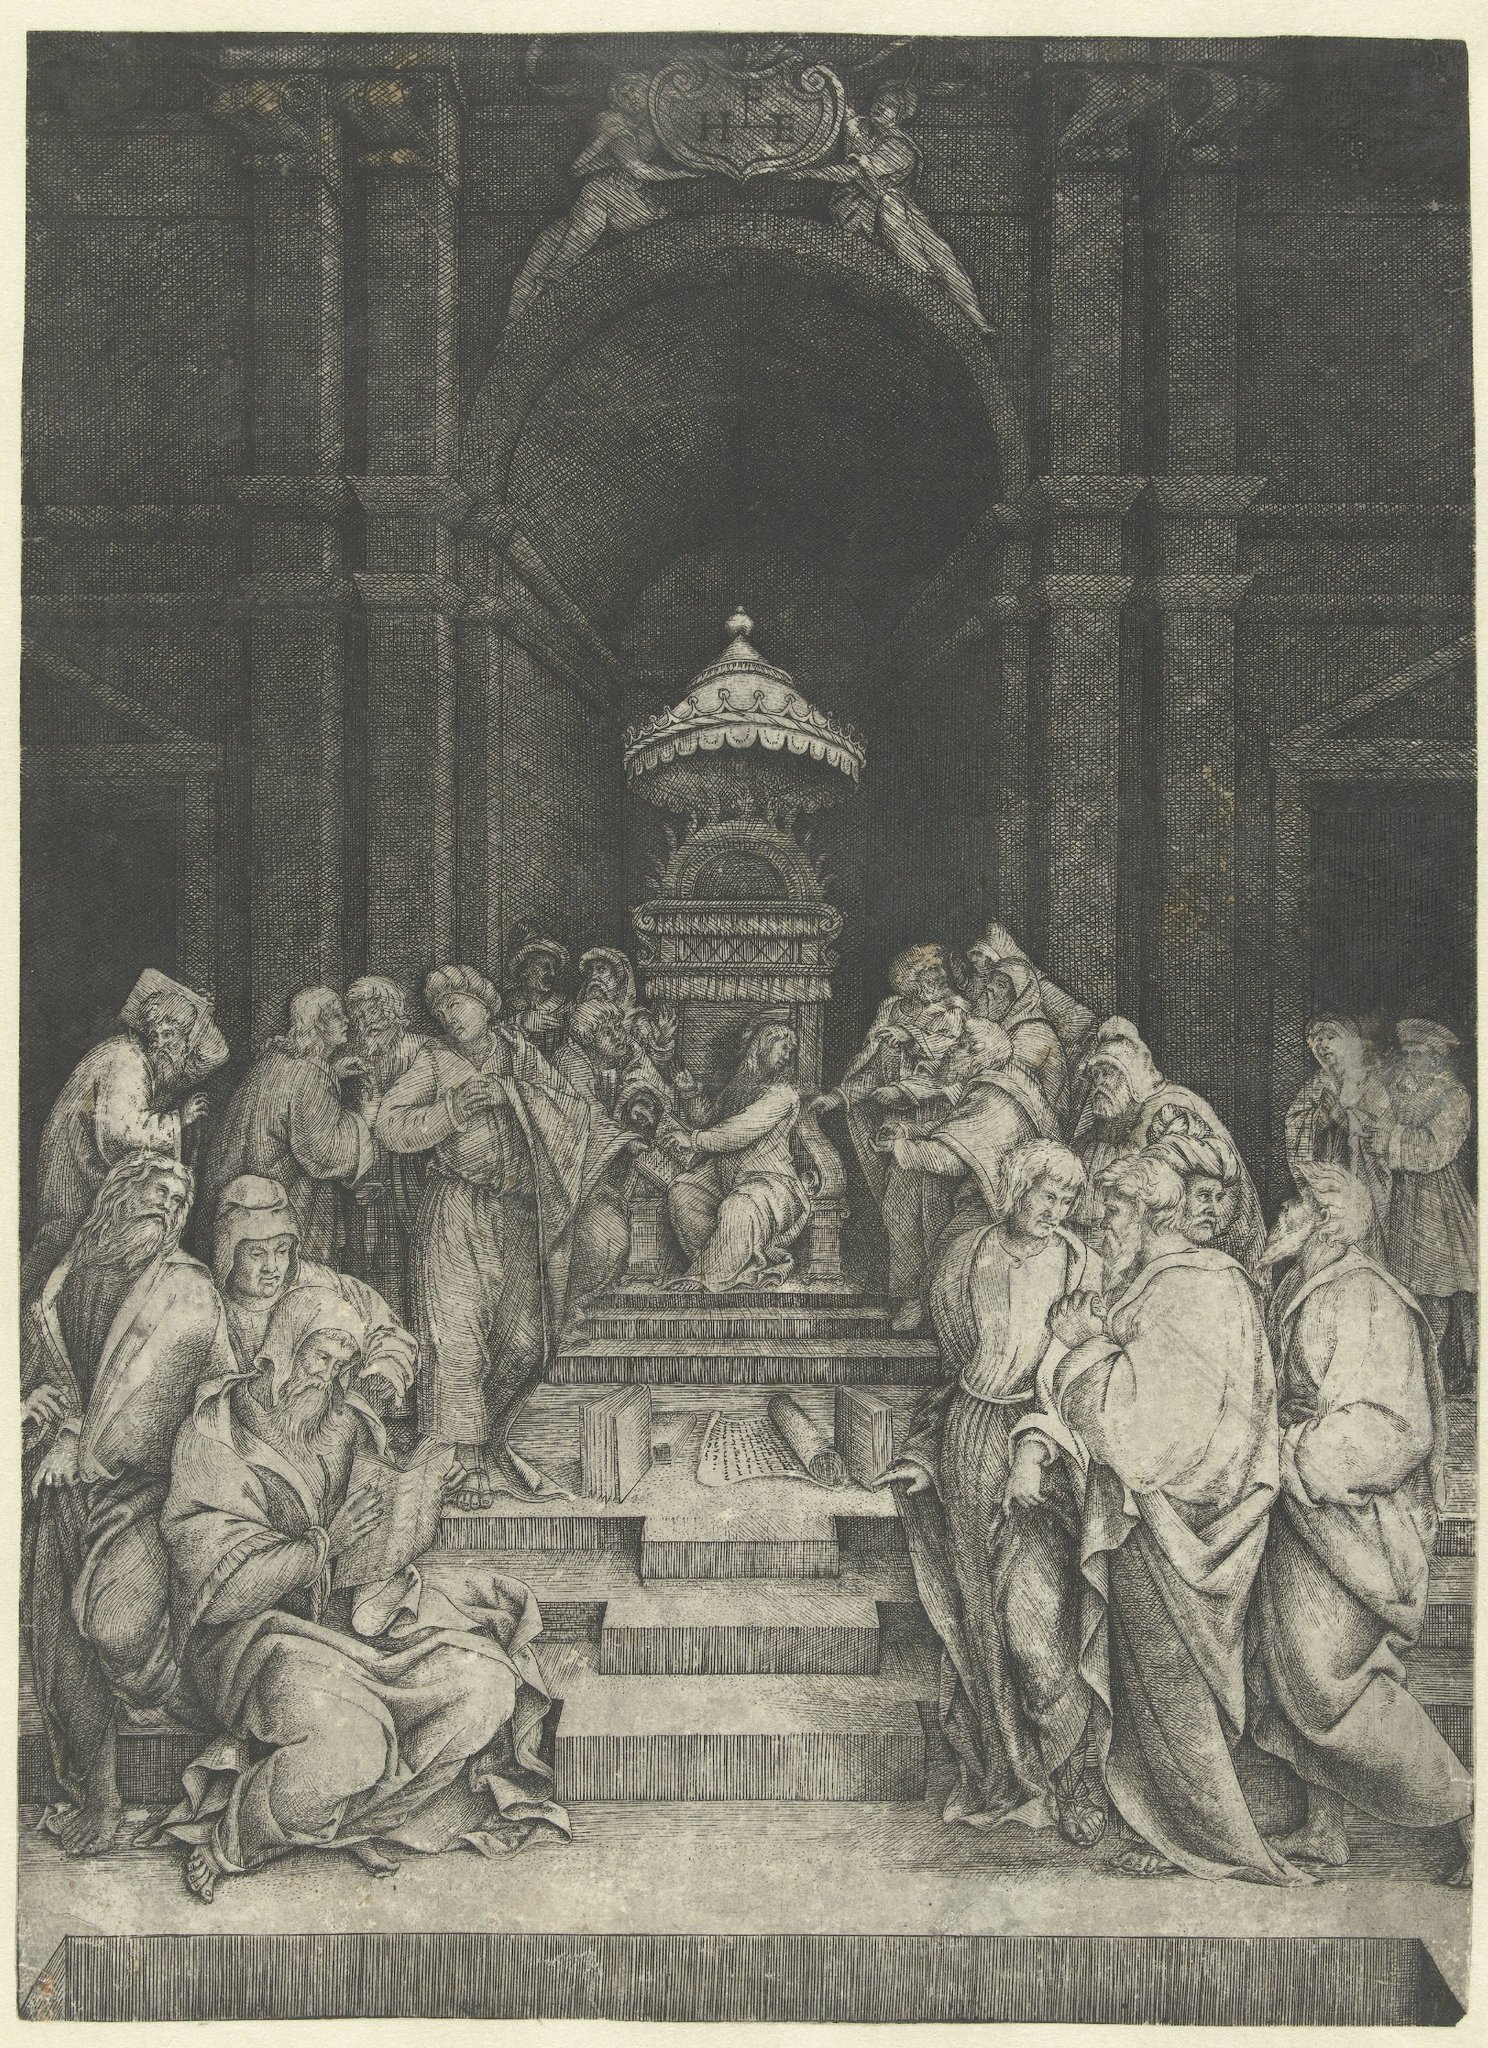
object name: print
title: Christus tussen schriftgeleerden in tempel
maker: monogrammist hfe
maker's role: print maker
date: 1500-1550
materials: paper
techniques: engraving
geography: italy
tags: christ's dispute with the doctors in the temple; he counts his arguments on his fingers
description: Christus in tempel zittend op troon. Hij wijst een tekst aan in een boek en schriftgeleerden staan aan weerszijden in gesprek